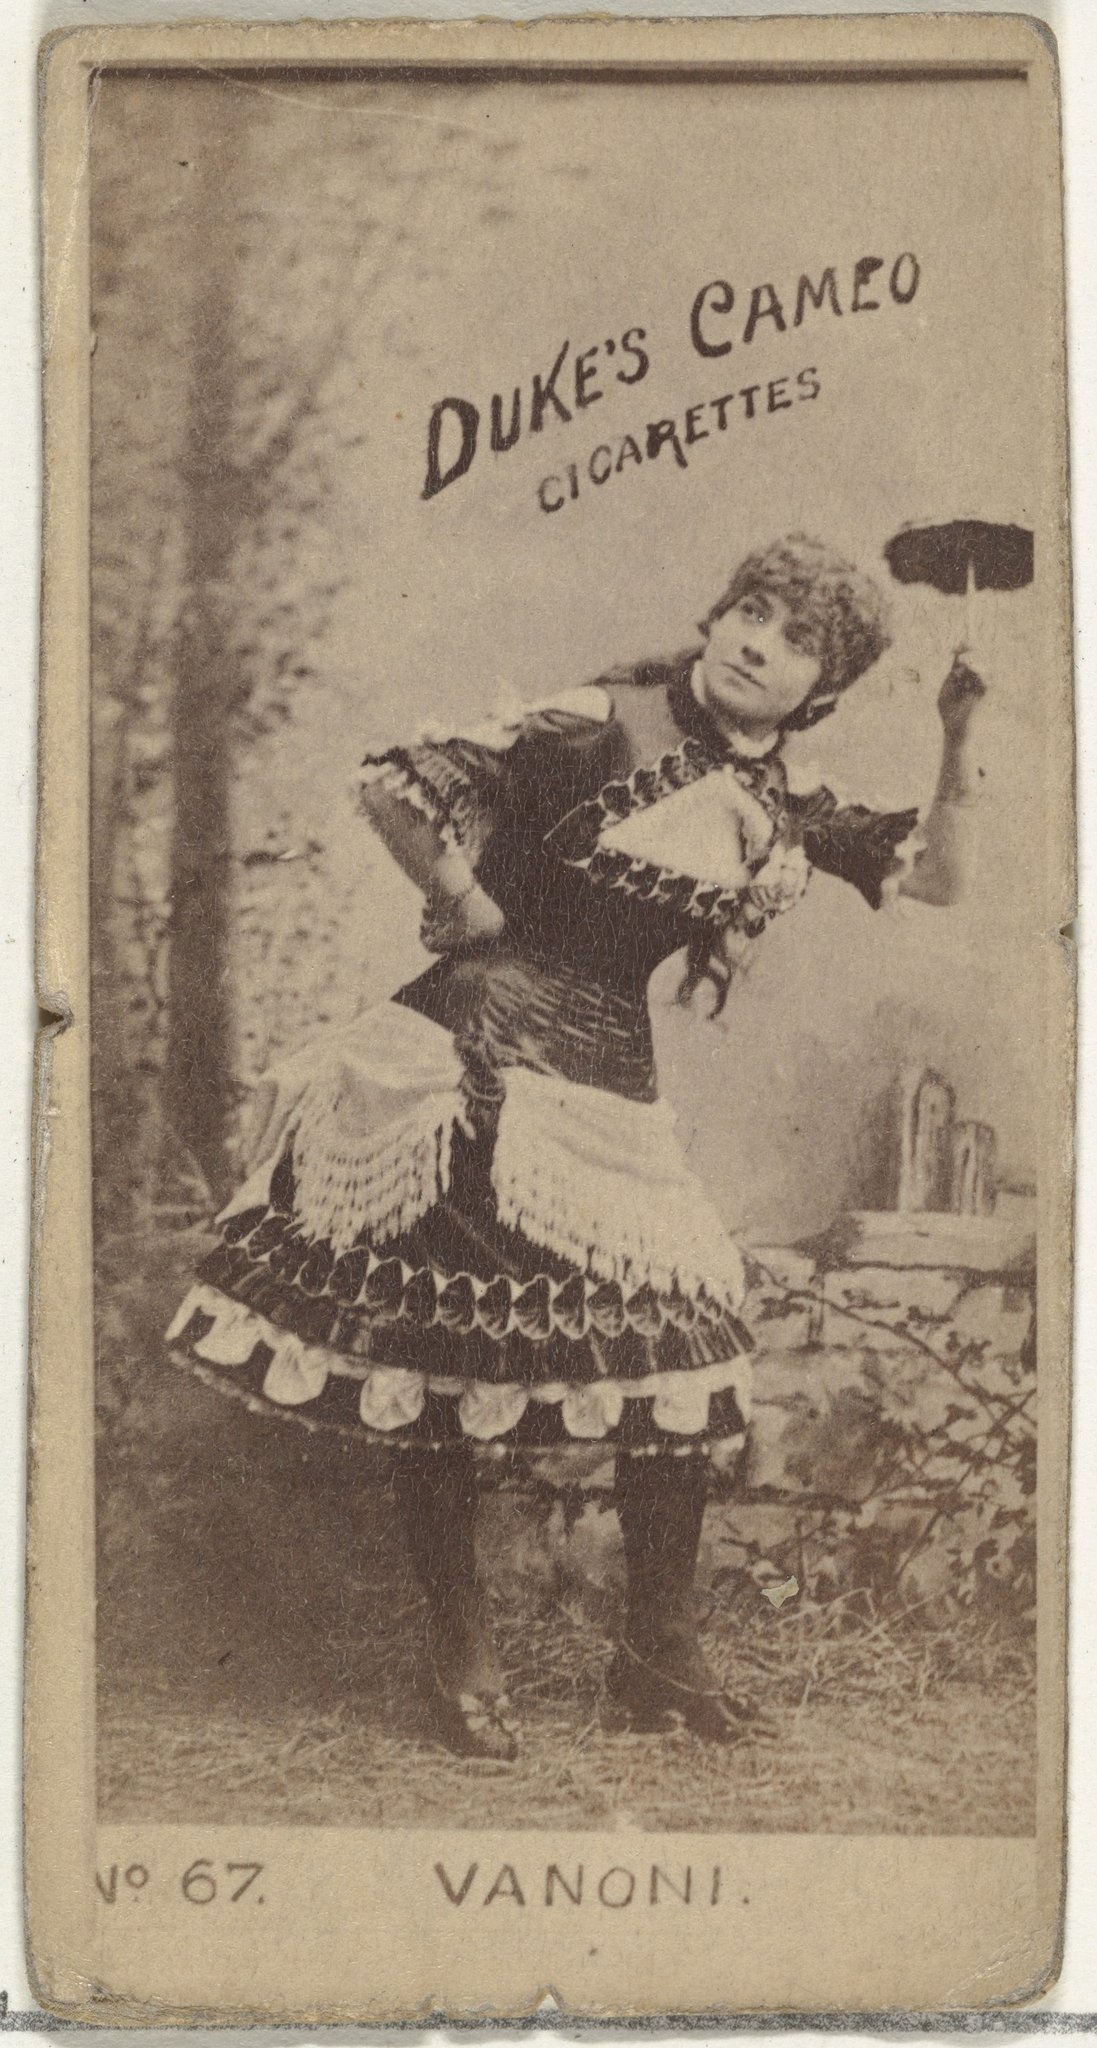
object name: photograph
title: Card Number 67, Miss Vanoni, from the Actors and Actresses series (N145-4) issued by Duke Sons & Co. to promote Cameo Cigarettes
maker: w. duke, sons & co.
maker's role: publisher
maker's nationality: american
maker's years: 1870-1920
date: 1880-1889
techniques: albumen silver print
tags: portraits,women,actresses